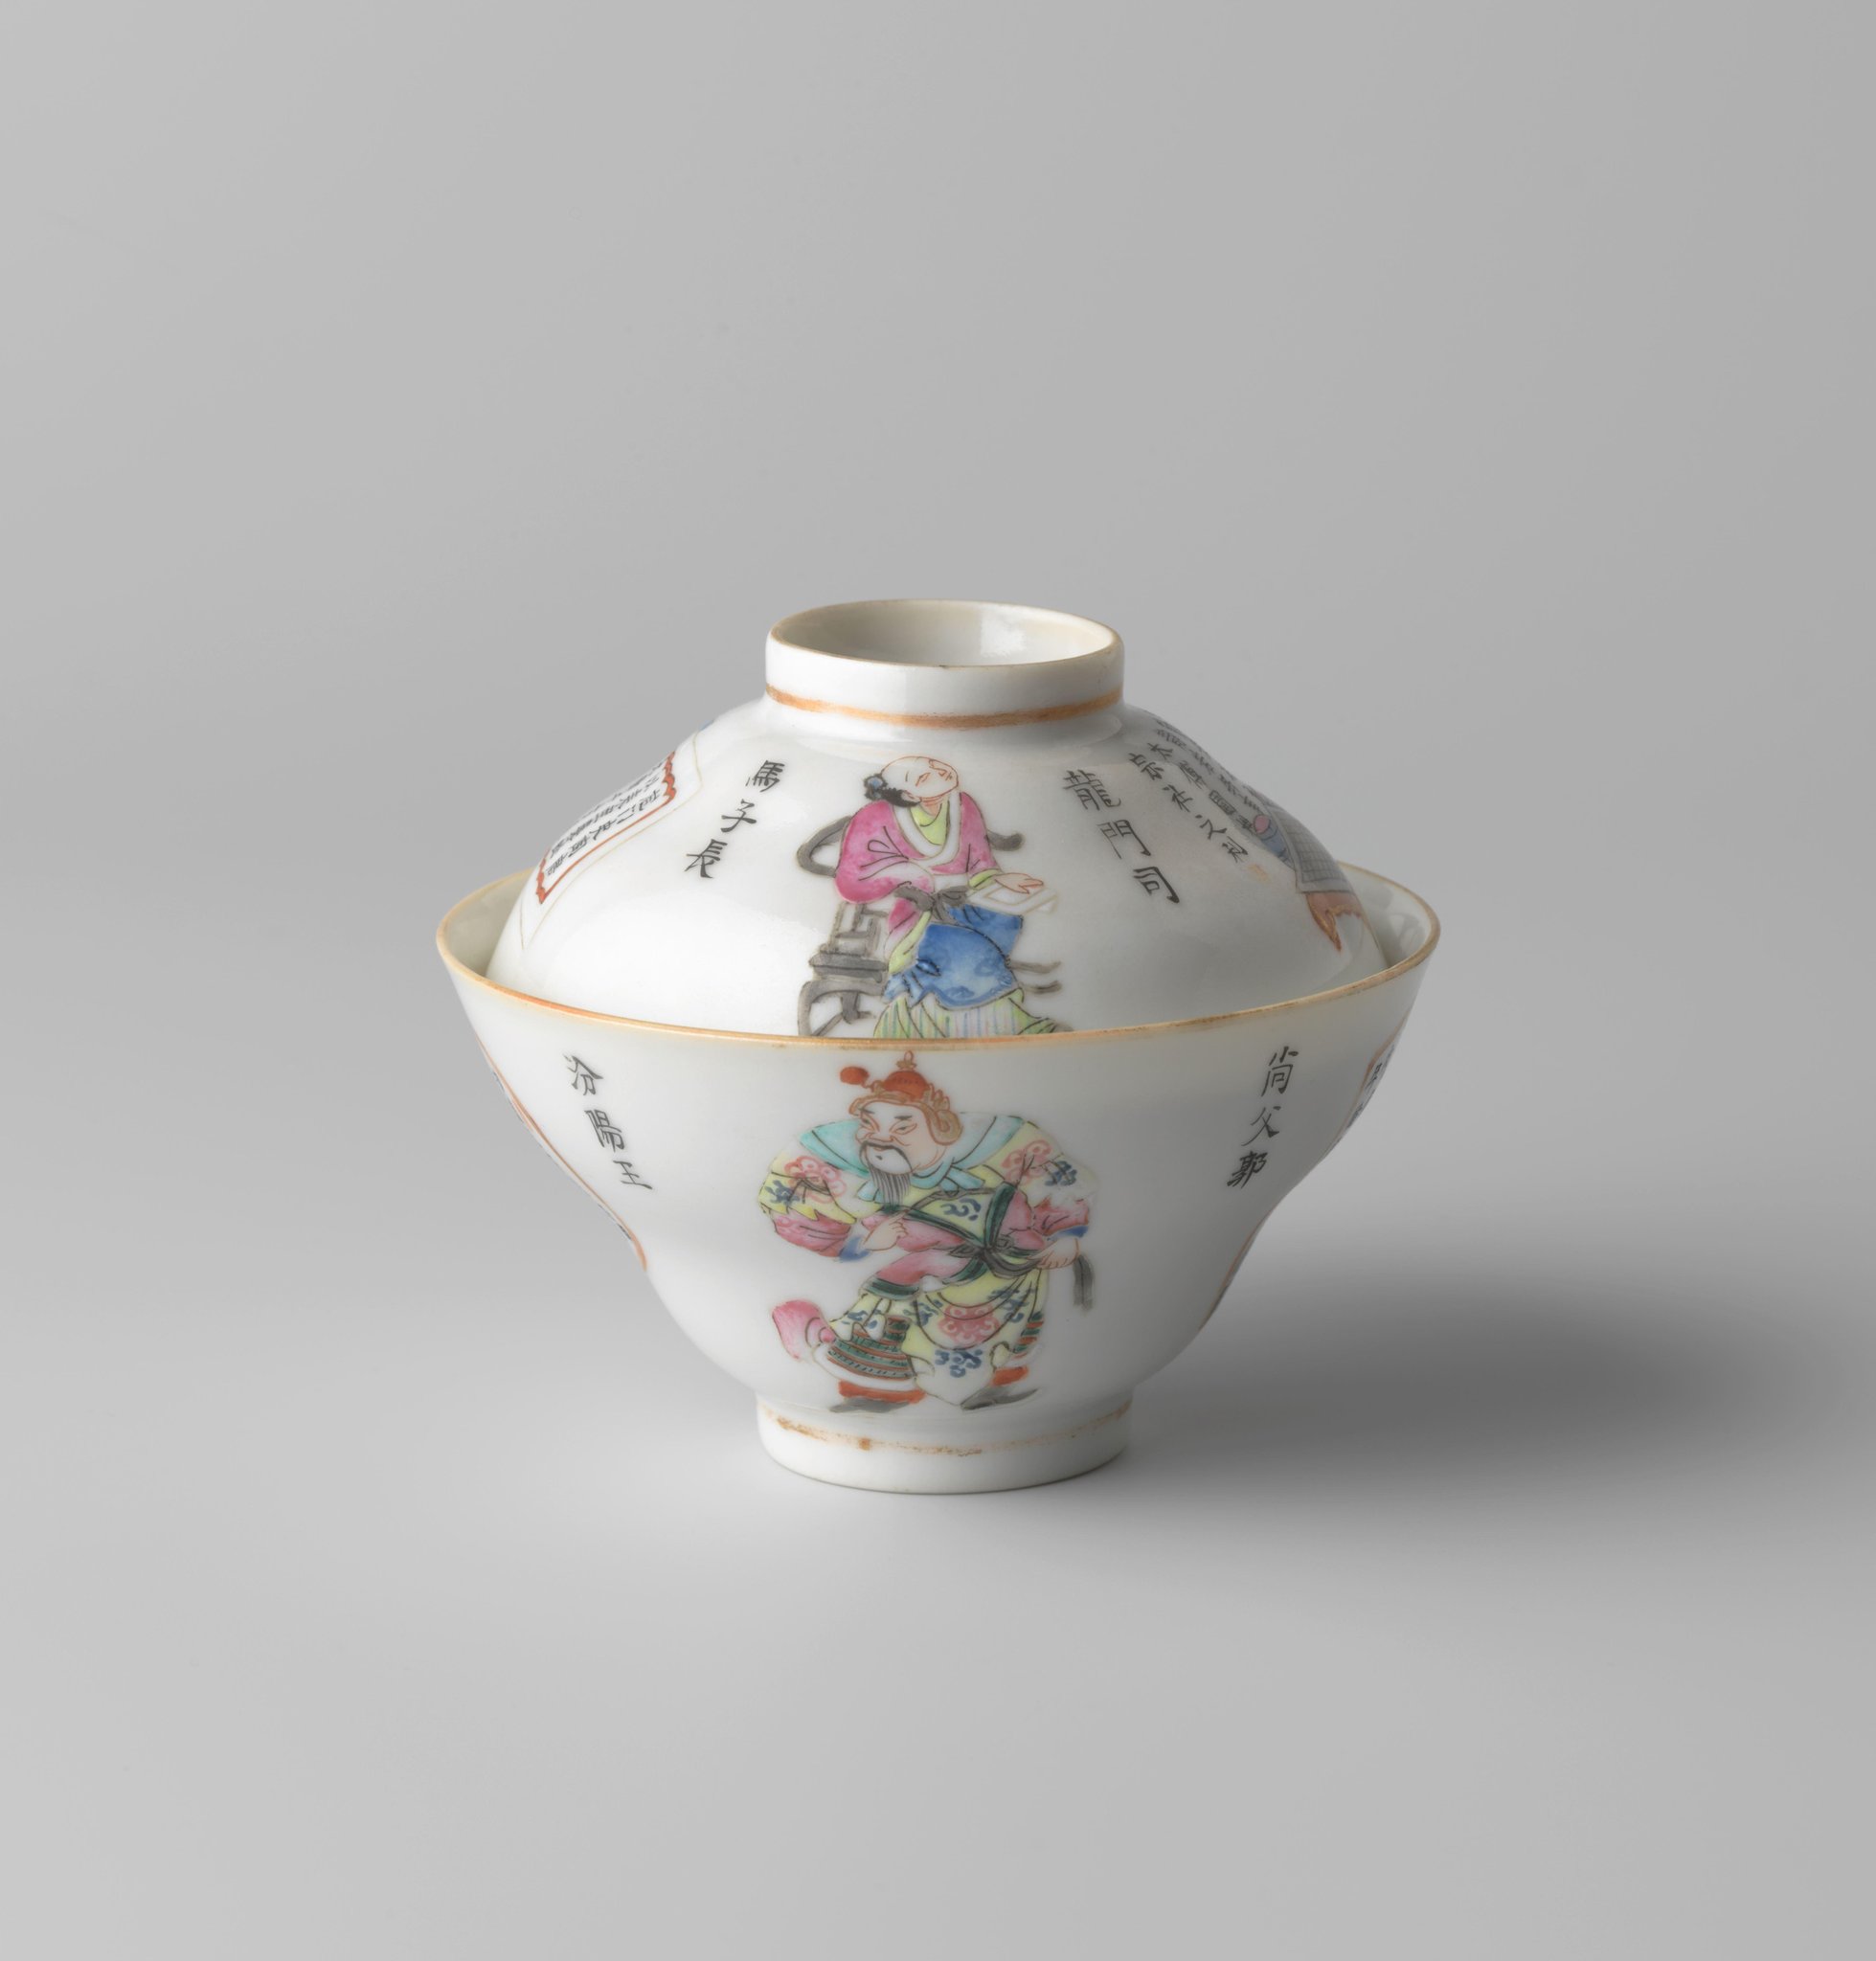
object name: covered cup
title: Covered cup with Chinese figures and inscriptions in panels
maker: Anonymous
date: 1800-1899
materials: glaze, gold, paint, porcelain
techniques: firing, gilding, turning, vitrification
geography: china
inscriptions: mark: ‘大 清 道 光 年 製’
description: Deksel van kop van porselein met een getrapte wand, beschilderd op het glazuur in blauw, rood, roze, groen, geel, zwart en goud. De deksel met dezelfde soort decoratie als de kop, met andere cartouches en personen. De deksel gemerkt met het zegelmerk van keizer Daoguang (?). Famille rose.